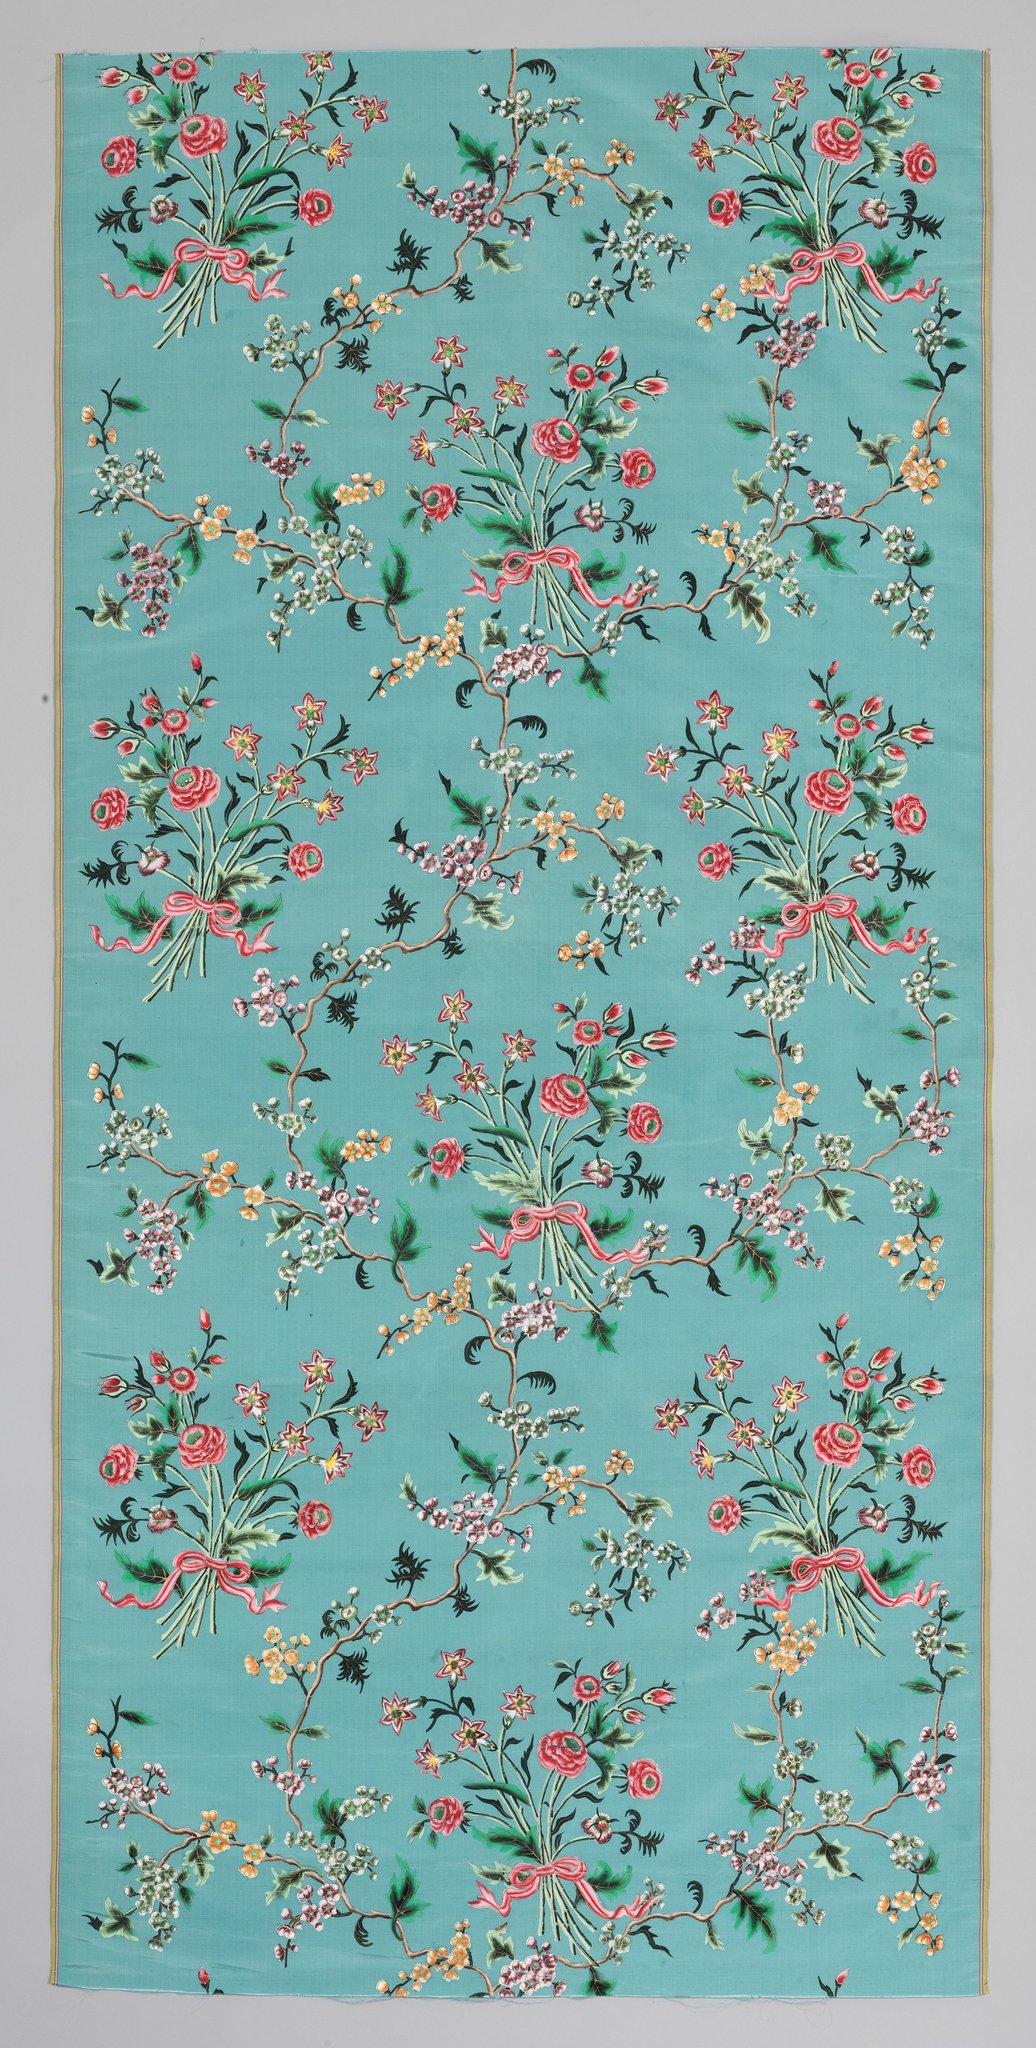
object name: length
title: Length of painted silk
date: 1734-1766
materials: gilt, pigment, silk, silver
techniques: painting, weave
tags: flowers